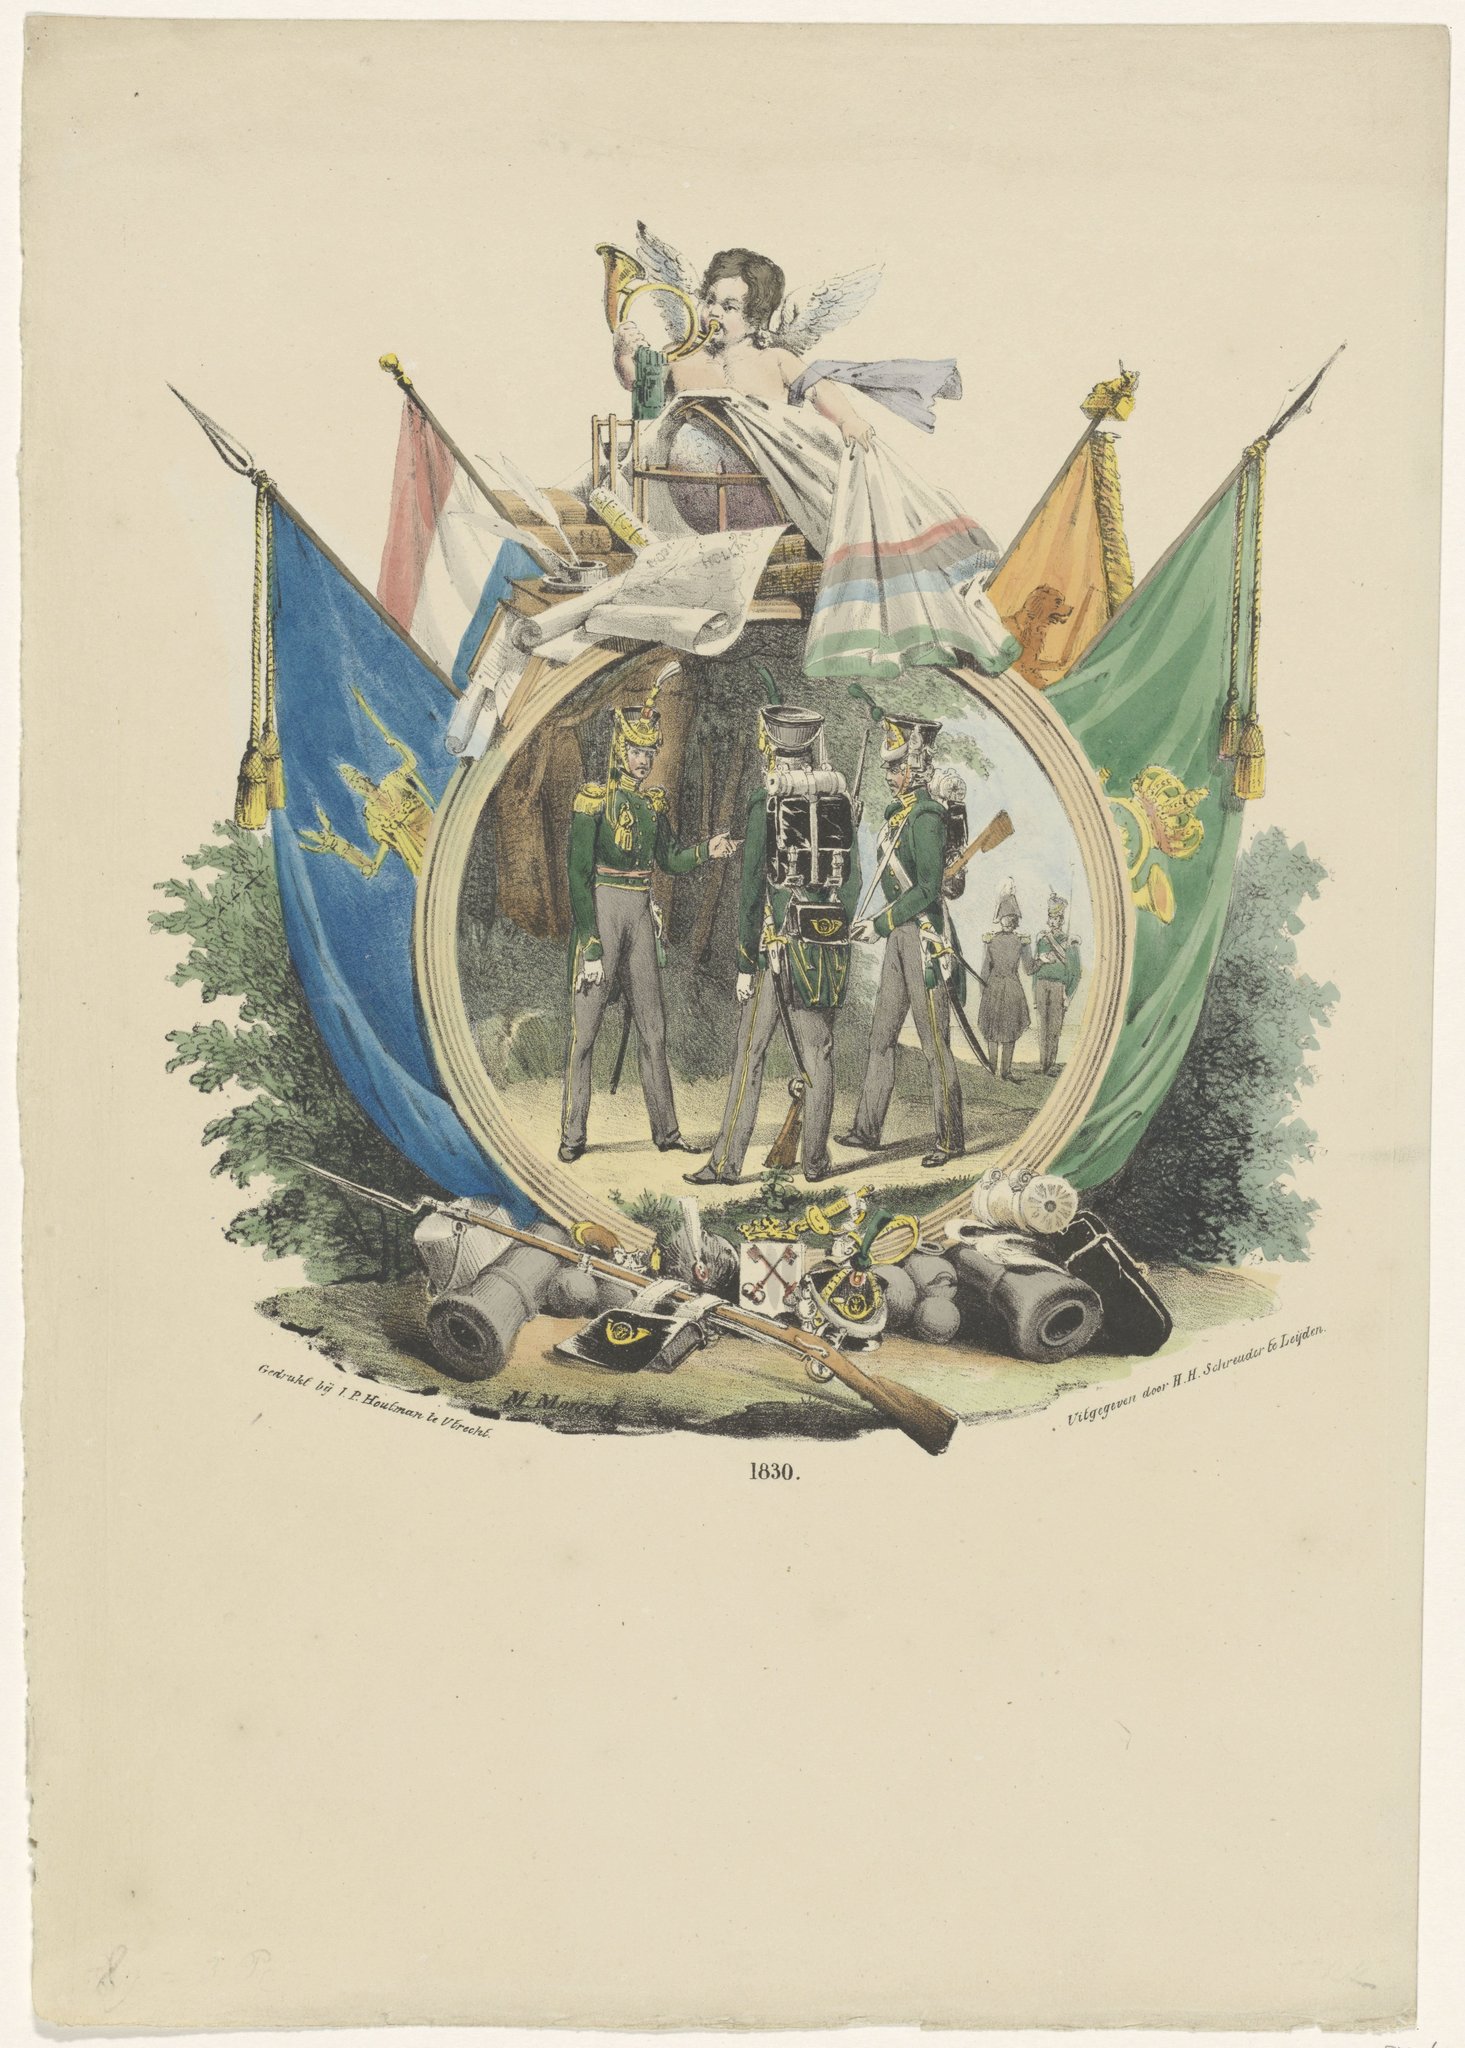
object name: print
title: Medaillon met Vrijwillige Jagers der Leidse Hogeschool, 1830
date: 1830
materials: paper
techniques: hand coloring, lithograph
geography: leiden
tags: (military) uniforms, clothes, costume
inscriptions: collector's mark: Lugt 2228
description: Allegorisch medaillon met een voorstelling van enkele Vrijwillige Jagers der Leidse Hogeschool, 1830. Op de grond voor het medaillon liggen wapens en delen van de wapenrusting bij het stadswapen van Leiden. Aan weerszijden vaandels, bovenaan attributen van de universitaire studie: boeken, pen en papier, met een putto die op een hoorn blaast. Zie ook de pendant.